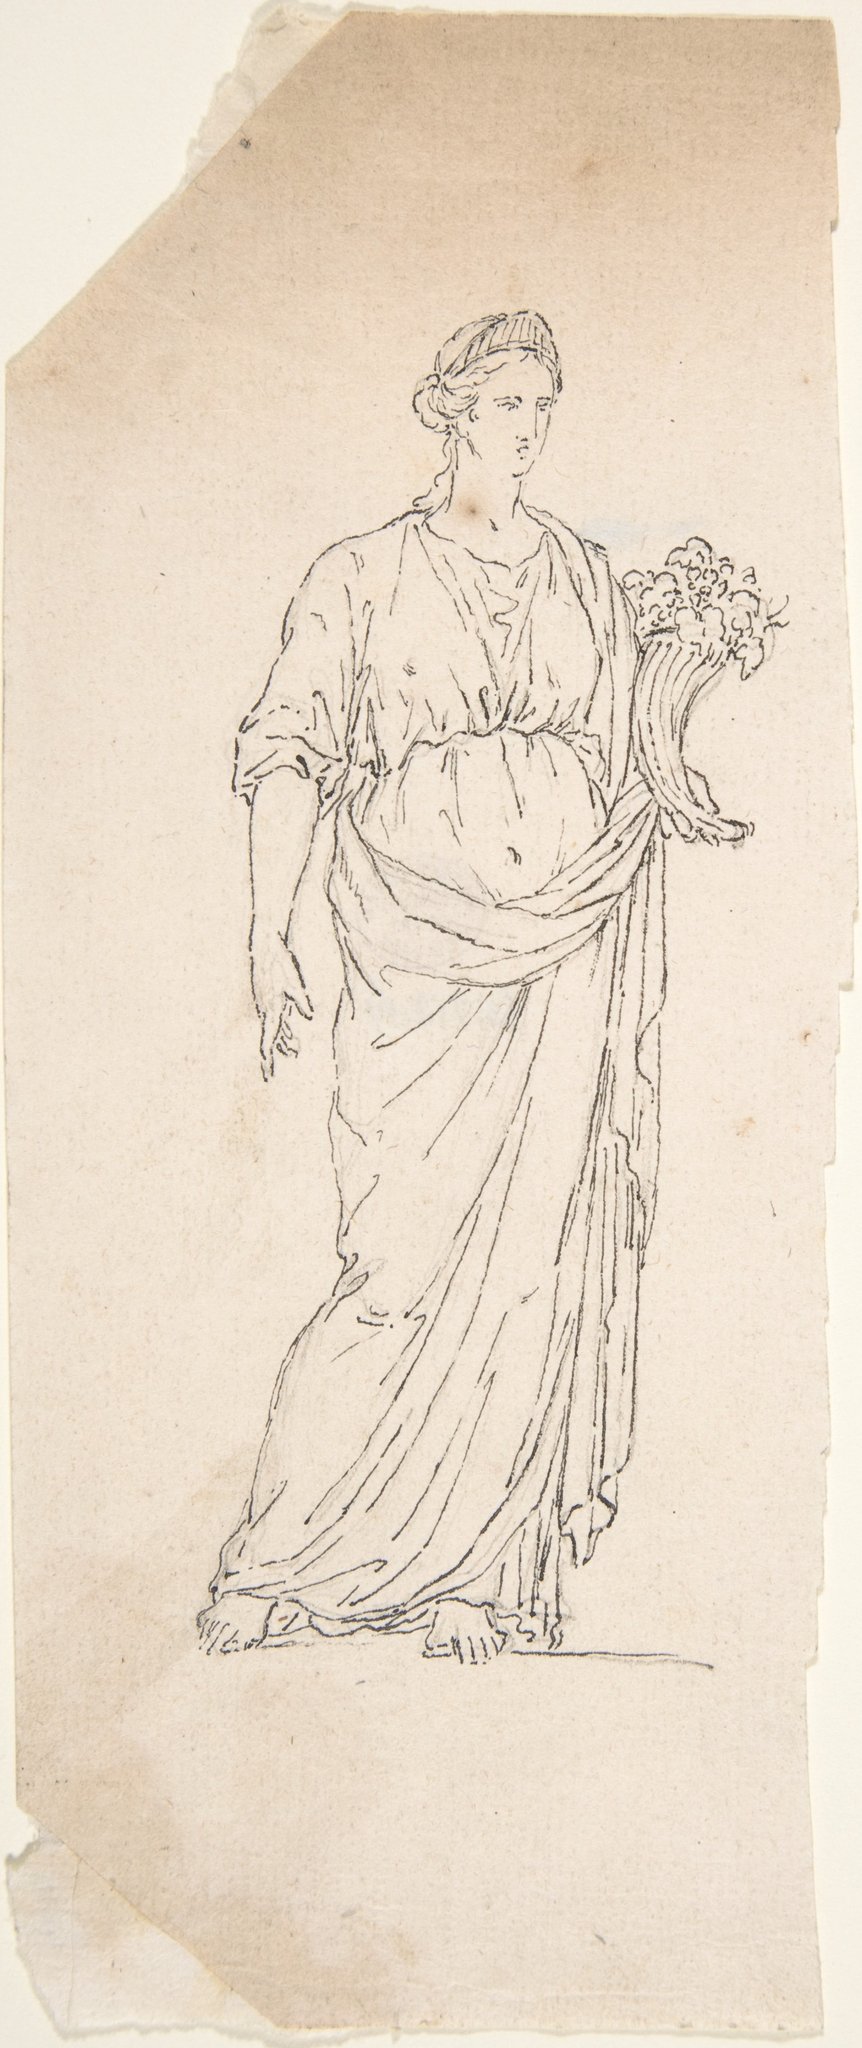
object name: drawing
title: Drawing of Female Statue with Cornucopia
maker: anonymous, french, 18th century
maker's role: artist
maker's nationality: french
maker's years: 1700-1800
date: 1701-1800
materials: graphite, ink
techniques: pen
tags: women,cornucopia